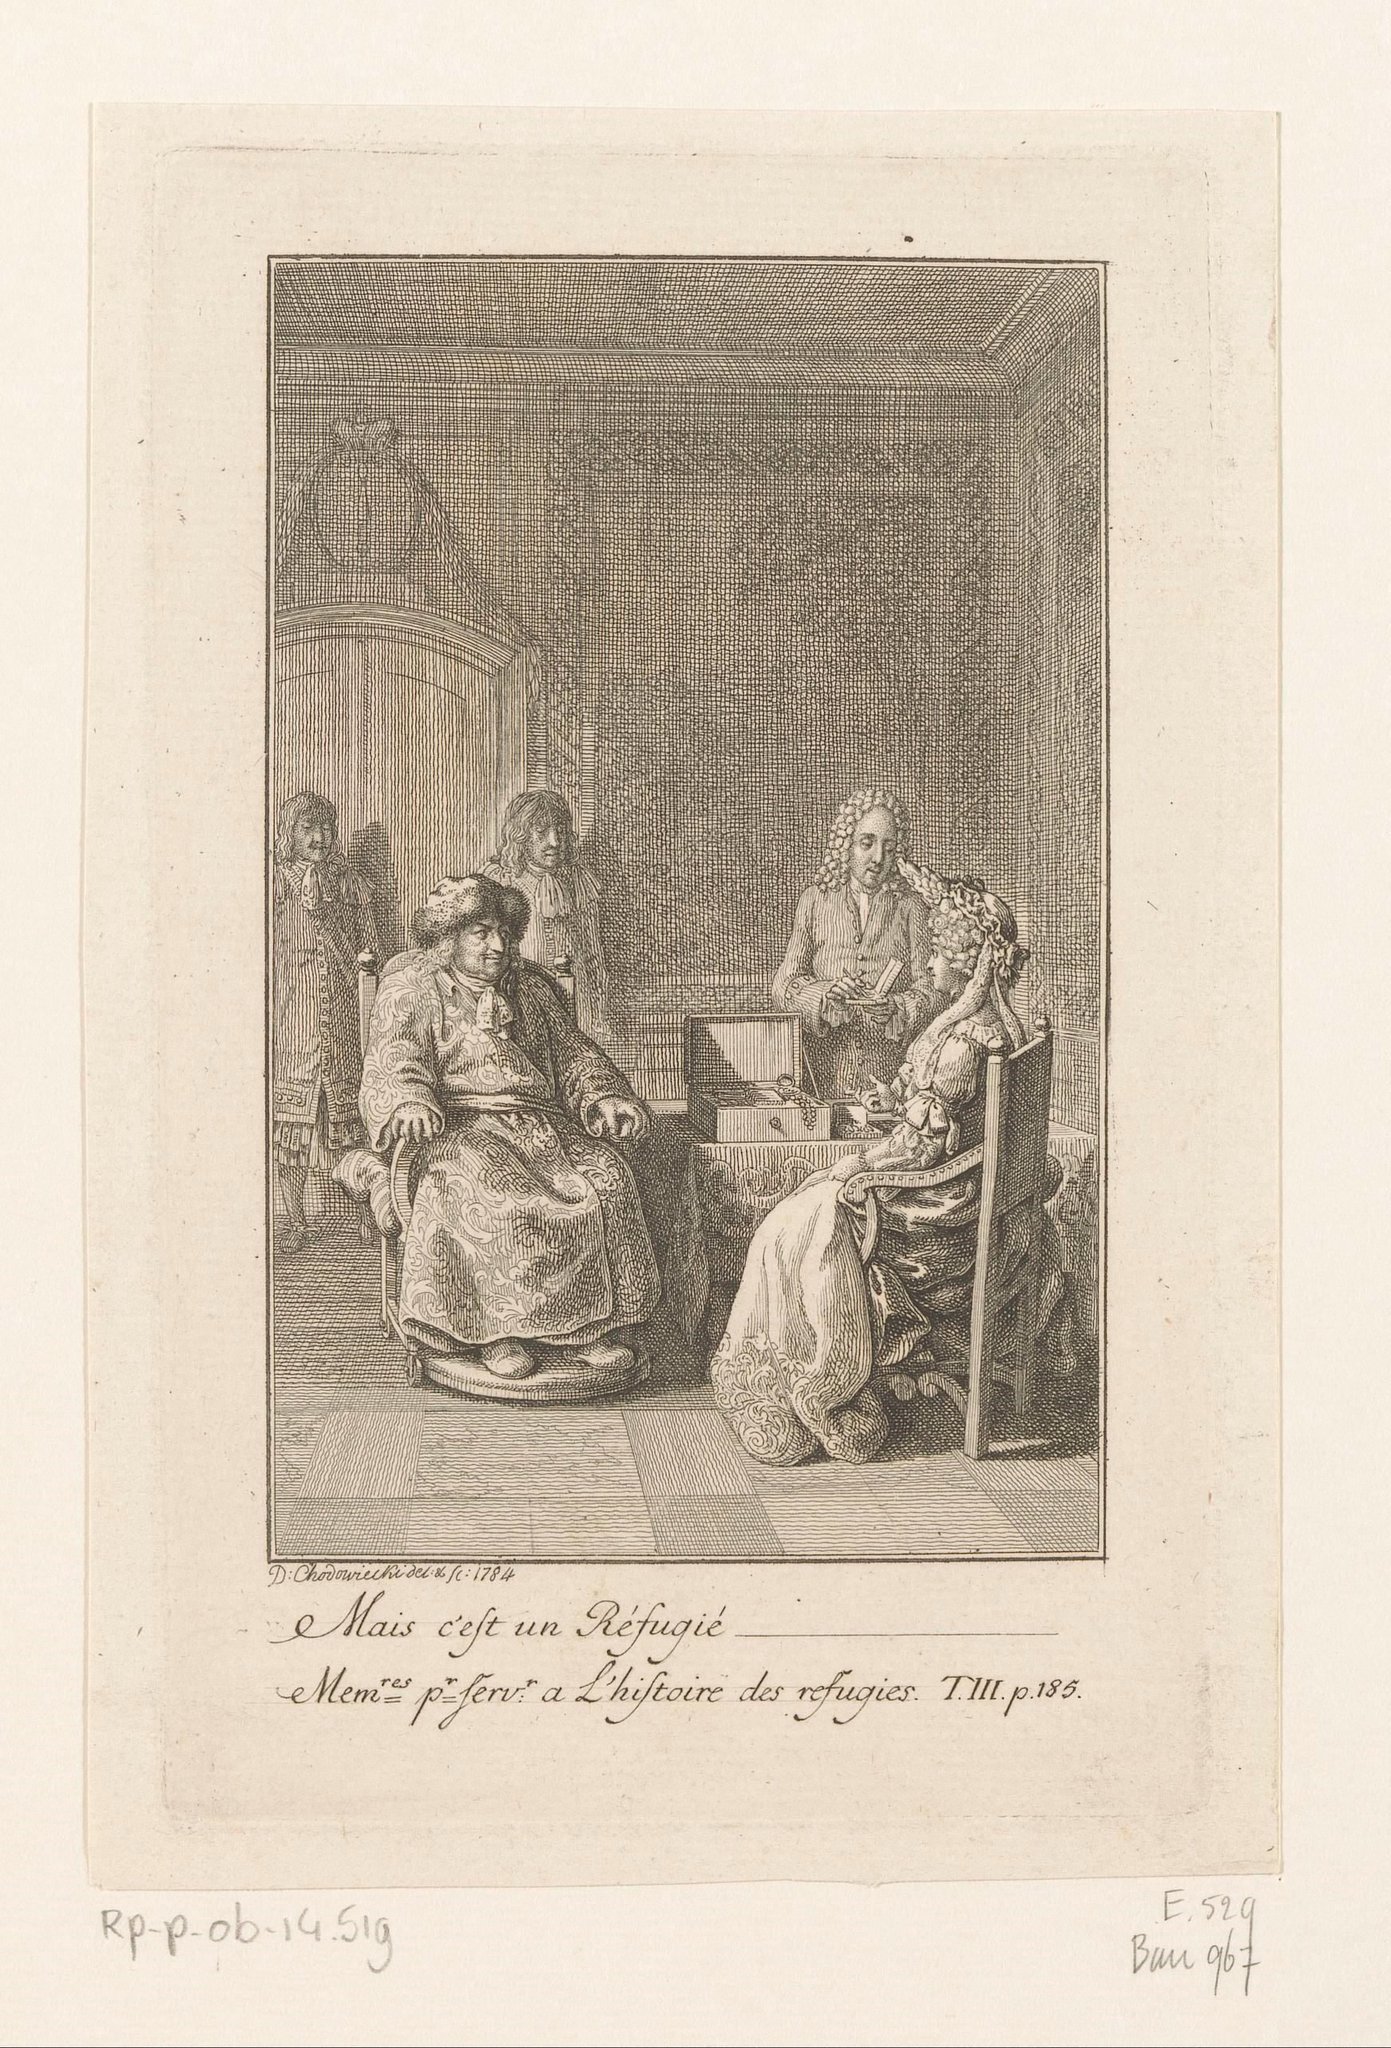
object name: print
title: Friedrich Wilhelm in zijn rolstoel naast de kroonjuwelen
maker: daniel nikolaus chodowiecki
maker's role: draughtsman, print maker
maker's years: 1726-1801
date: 1784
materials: paper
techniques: etching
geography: berlin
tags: berlin, frederik willem van brandenburg (i), wheelchair, bathchair, ruler, sovereign, jewel-box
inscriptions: collector's mark: Lugt 2228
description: Prent gebruikt voor: Erman, Jean Pierre. Mémoires pour servir à l'histoire des réfugiés françois dans les états du roi. 9 dln. Berlijn: s.n., 1784, dl. 3.